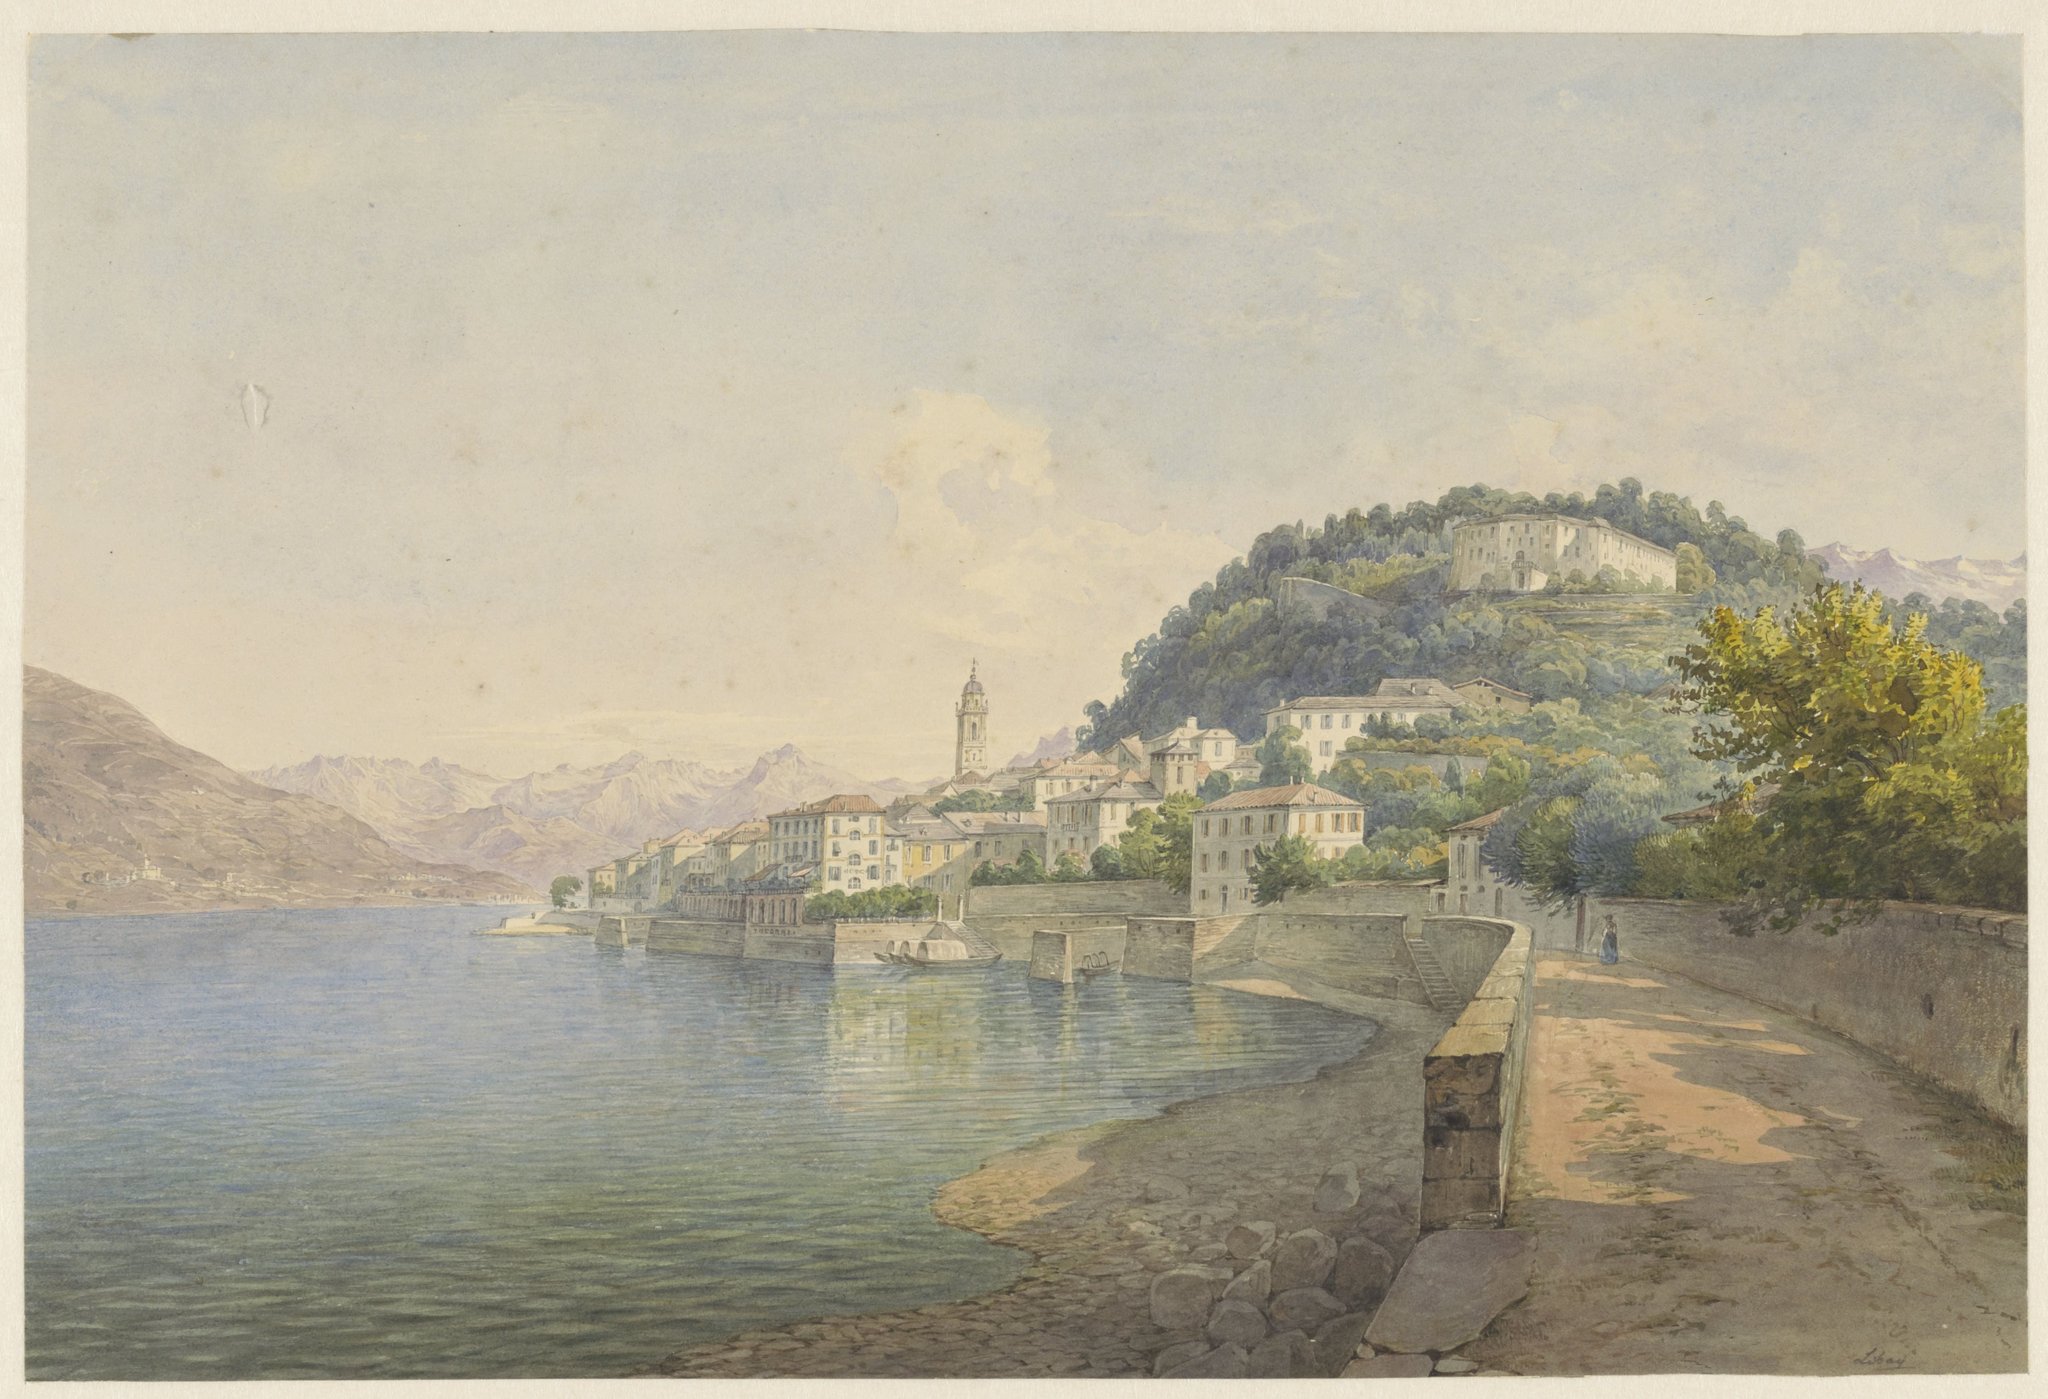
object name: drawing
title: Bellagio aan het Comomeer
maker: karoly lajos libay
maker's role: draughtsman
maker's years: 1814-1888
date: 1824-1888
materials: cardboard, pencil, watercolor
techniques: brush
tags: lake, prospect of city, town panorama, silhouette of city (+ city(-scape) with figures, staffage)